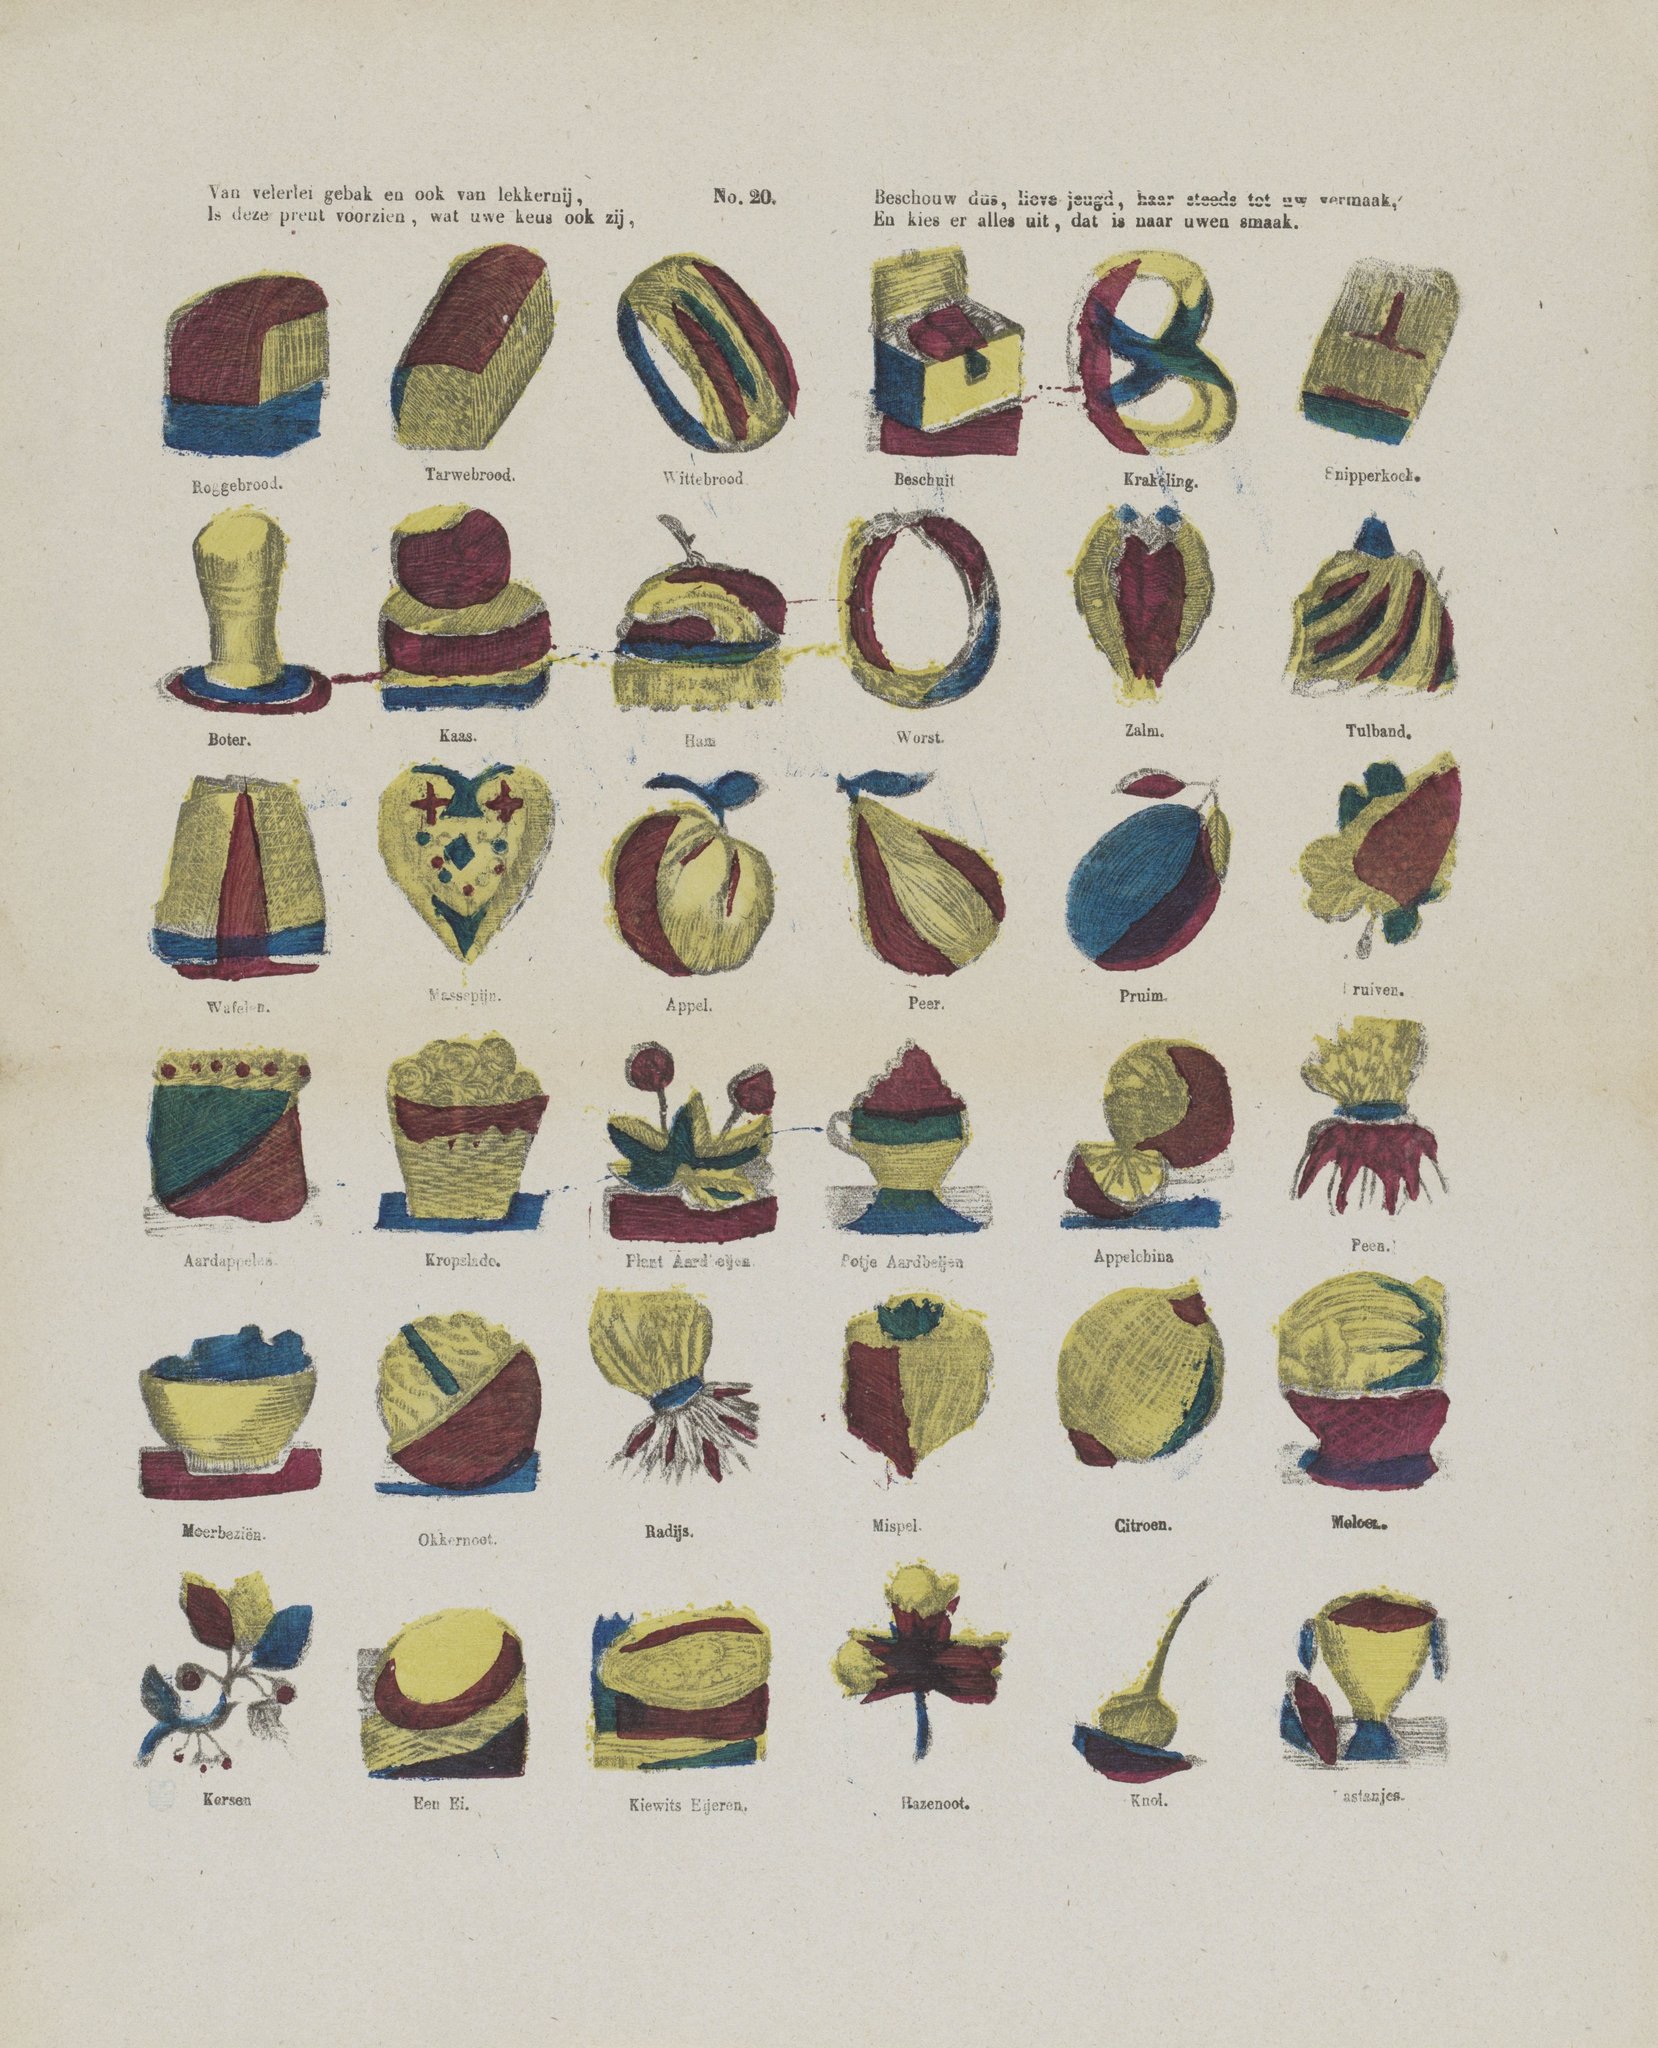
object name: print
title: Van velerlei gebak en ook van lekkernij, / Is deze prent voorzien, wat uwe keus ook zij, / Beschouw dus, lieve jeugd, haar steeds tot uw vermaak, / En kies er alles uit, dat is naar uwen smaak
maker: Anonymous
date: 1848-1881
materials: paper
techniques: colour, letterpress printing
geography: den bosch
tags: vegetables, cake, tart, pastry, bread, loaf, fruits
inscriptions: collector's mark: Lugt 2760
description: Blad met 36 voorstellingen van etenswaren, zoals roggebrood, zalm, peer en knol. Onder elke afbeelding een onderschrift. Genummerd midden boven: No. 20.